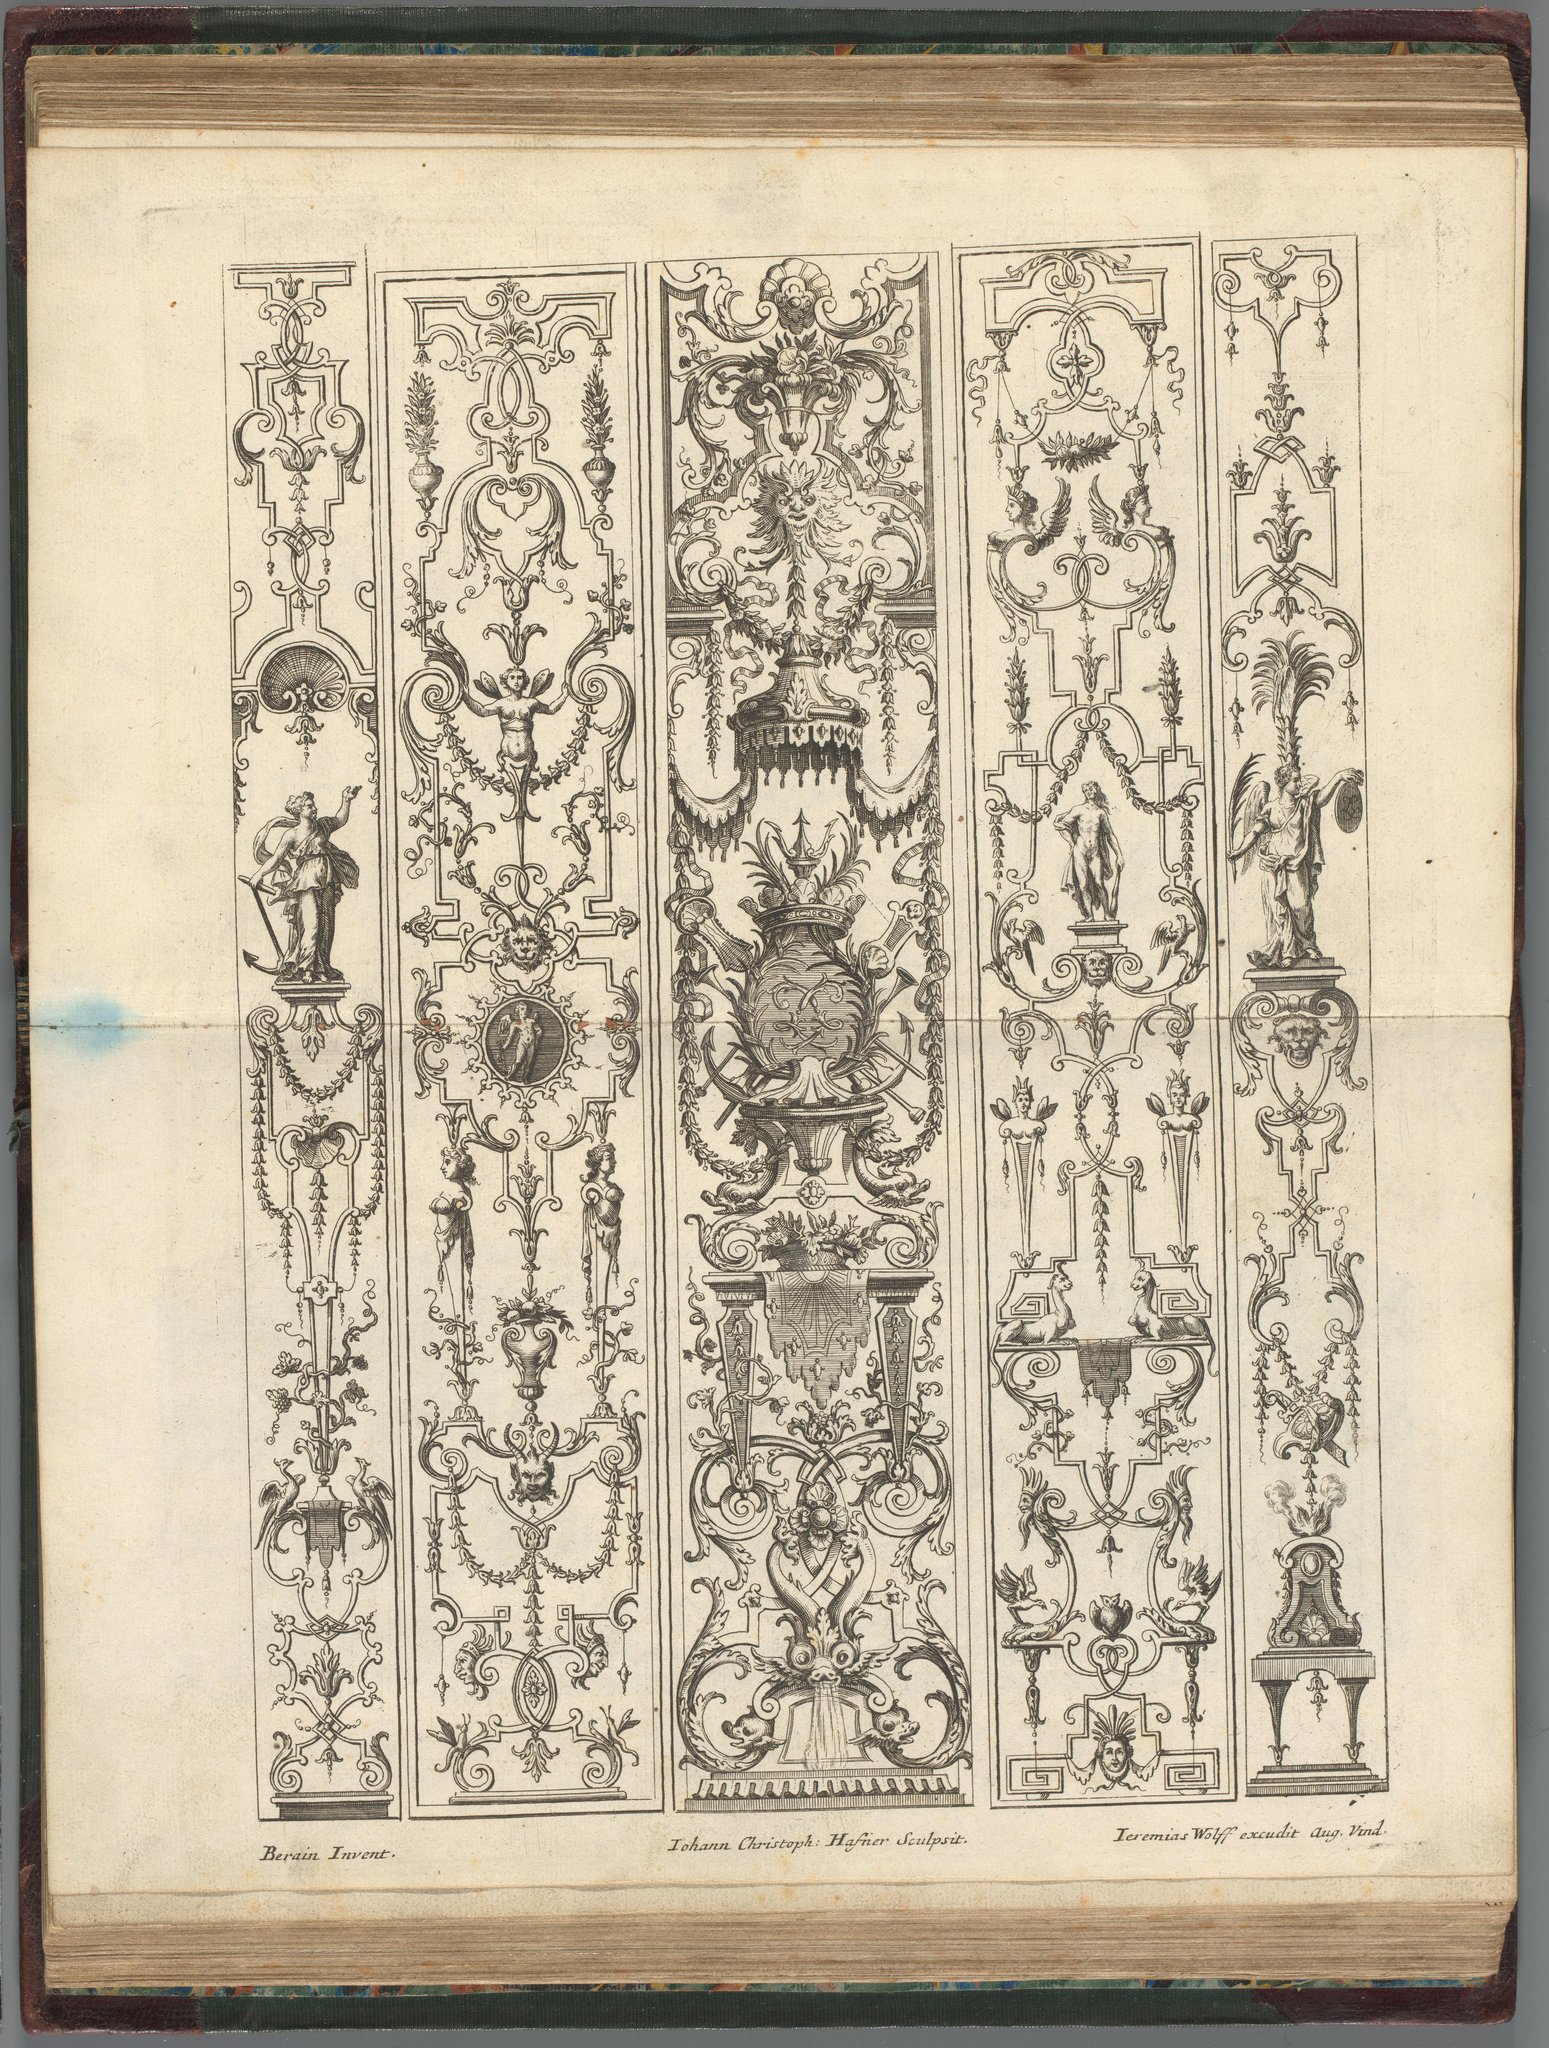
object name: print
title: Compositie met heraldisch wapen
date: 1686-1724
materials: paper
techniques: etching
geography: augsburg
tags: ornaments ~ art, parts of ship's exterior: anchor, armorial bearing, heraldry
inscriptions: signature: ‘Iohann Christoph Hafner Sculpsit.’, signature: ‘Ieremias Wolff excudit Aug. Vind.’, signature: ‘Berain Invent.’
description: Een decoratieve compositie bestaand uit vijf panelen. Links een vrouwelijk figuur met een anker. Daarnaast een putto met een boog. In het midden een heraldisch wapen met kroon onder een baldakijn. Daarnaast een mannelijke figuur met een knuppel. Rechts een engel met een palmtak in zijn rechterhand, hetzelfde wapenschil in zijn linkerhand en een palmboom op zijn hoofd. Prent maakt deel uit van een album. Hoogstwaarschijnlijk gespiegelde kopie naar Frans origineel.